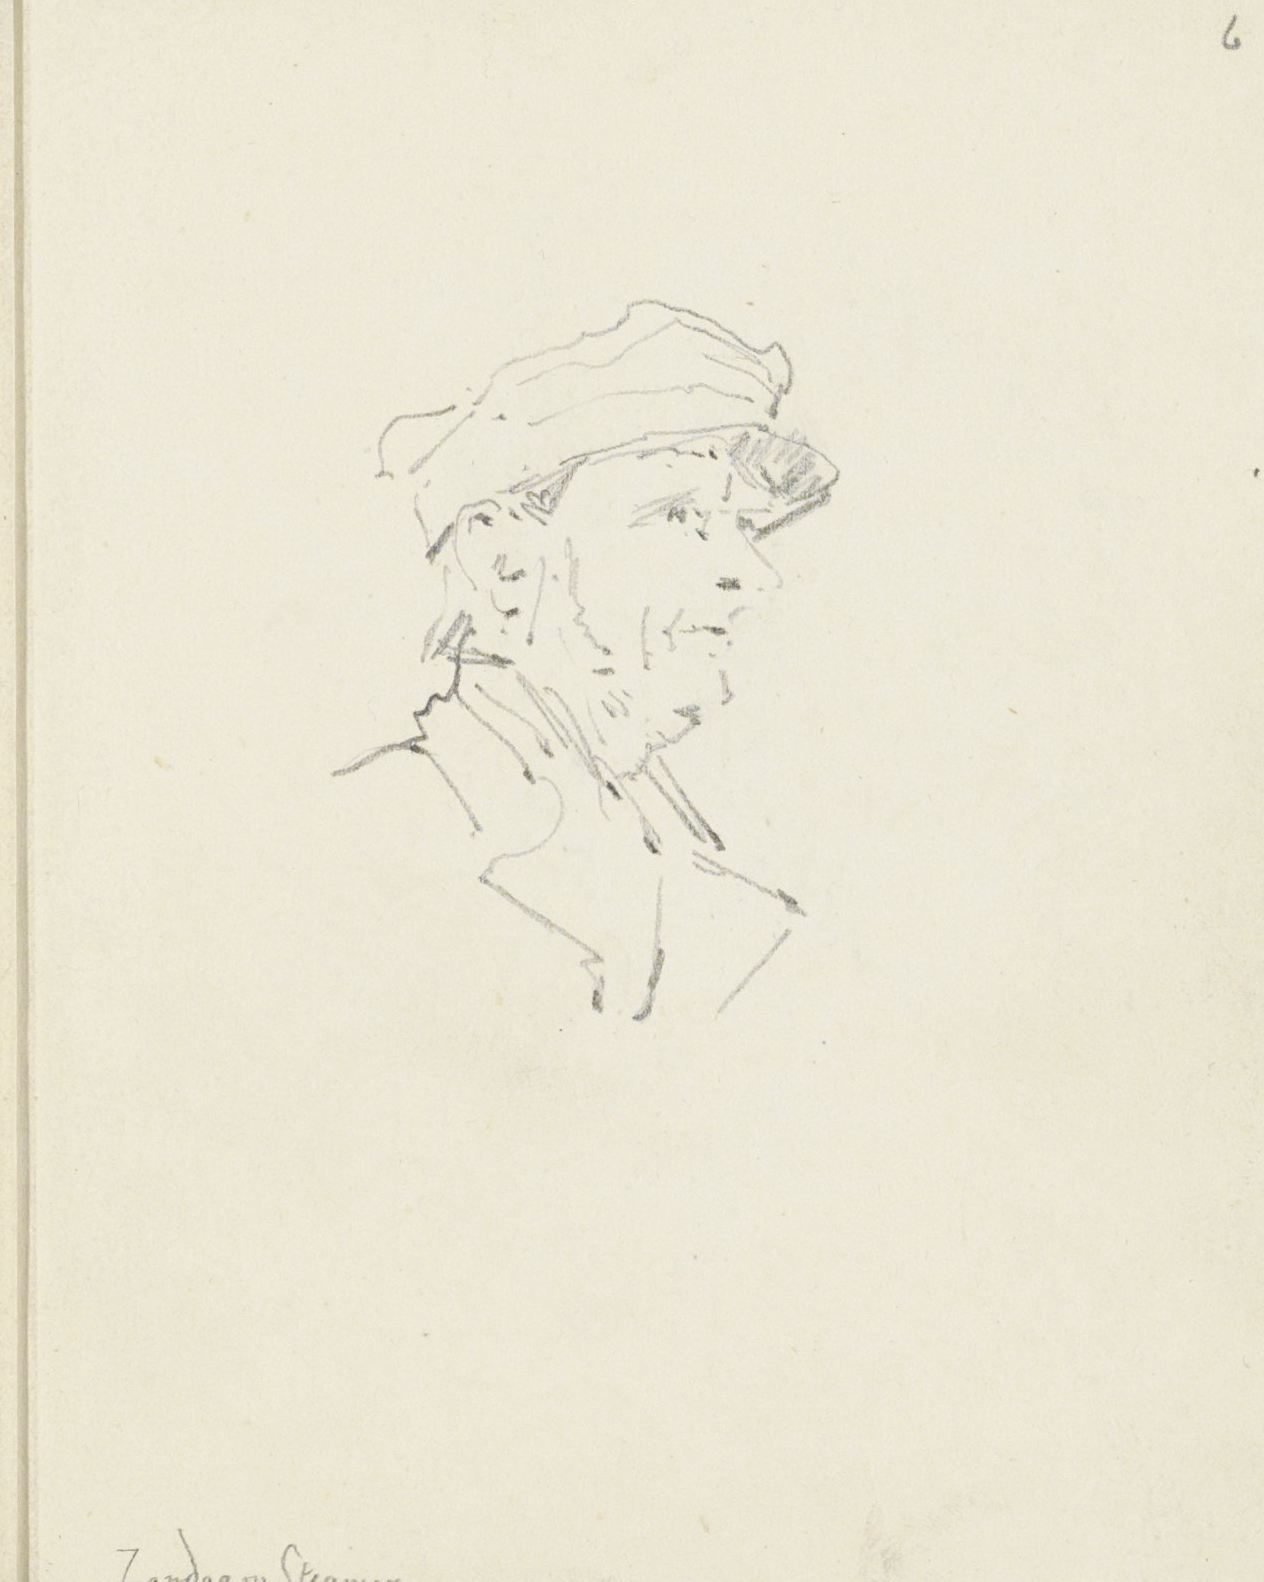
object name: sketchbook leaf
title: Hoofd van een man met een pet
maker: alfred william rich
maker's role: draughtsman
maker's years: 1856-1921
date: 1892-1893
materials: paper, pencil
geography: zaandam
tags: head (human), head-gear: cap (+ men's clothes)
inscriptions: annotation: ‘Zamdaam[sic] Steamer’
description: Reiziger getekend op de stoomboot naar Zaandam. Blad 6 recto uit een schetsboek met 86 bladen.